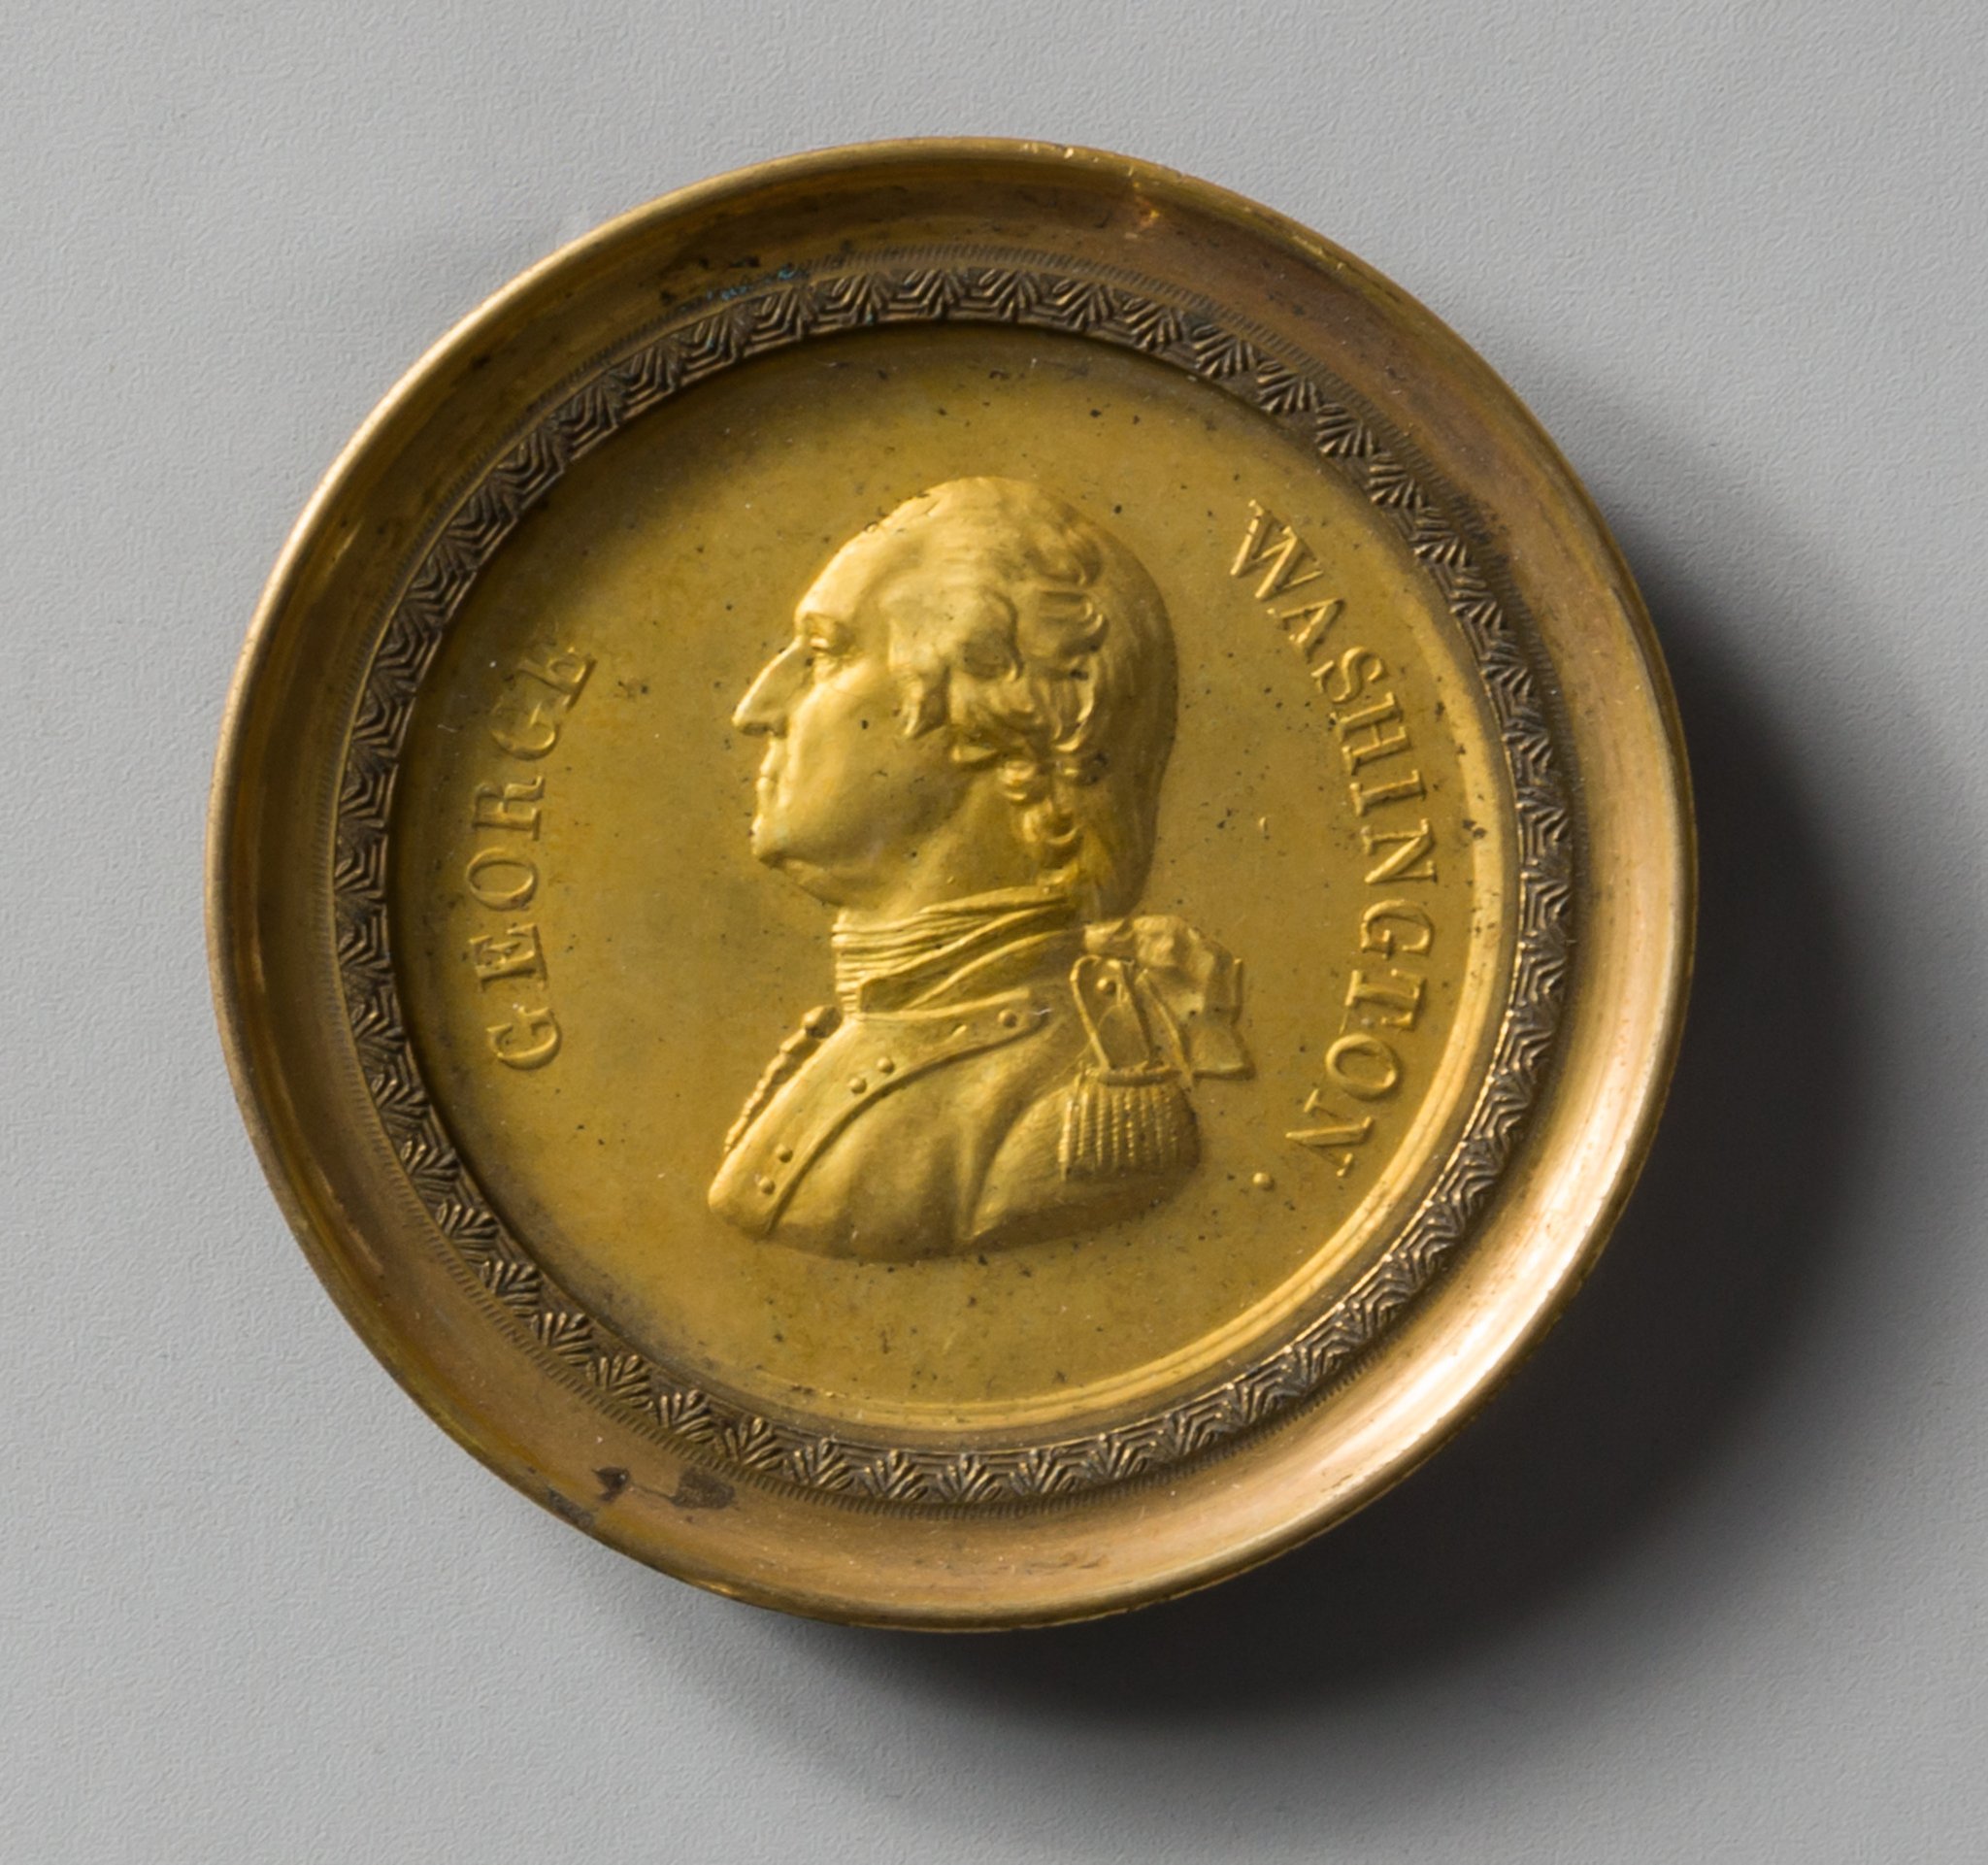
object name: medal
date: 1800-1830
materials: copper gilt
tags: george washington,profiles